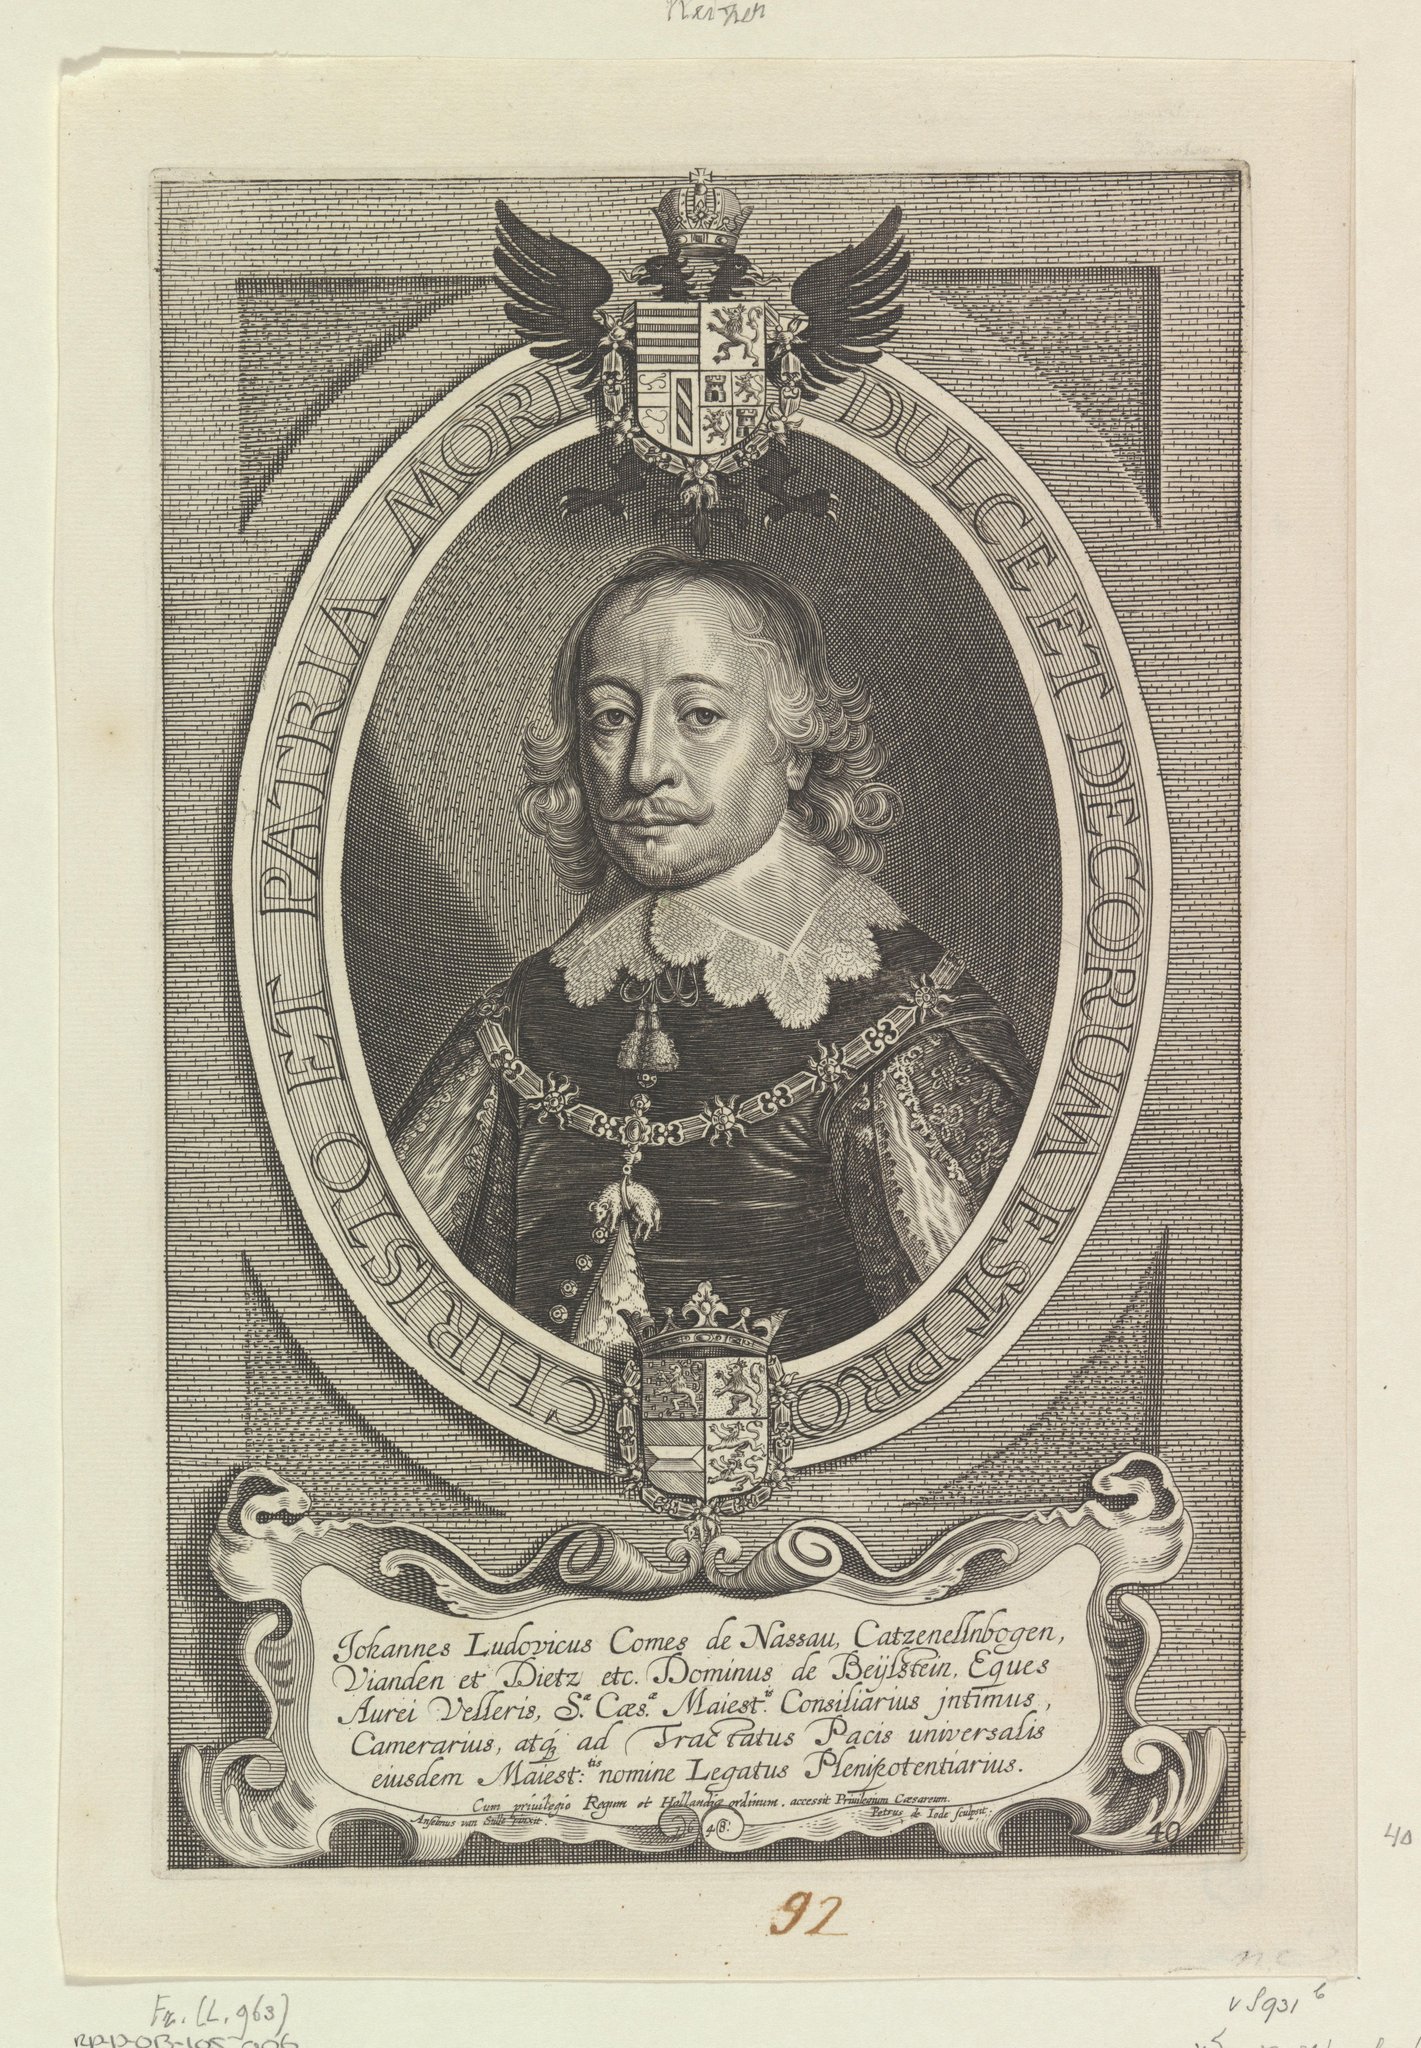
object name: print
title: Portret van Johan Lodewijk, graaf van Nassau-Hadamar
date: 1648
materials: paper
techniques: engraving, etching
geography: antwerp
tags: knighthood order of the golden fleece - insignia of a knighthood order, e.g.: badge, chain (with name of order)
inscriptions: collector's mark: Lugt 963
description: De hier vermelde titel verwijst naar de hoogst verkregen titel van de geportretteerde, niet per se naar de titel die de geportretteerde op deze voorstelling draagt.